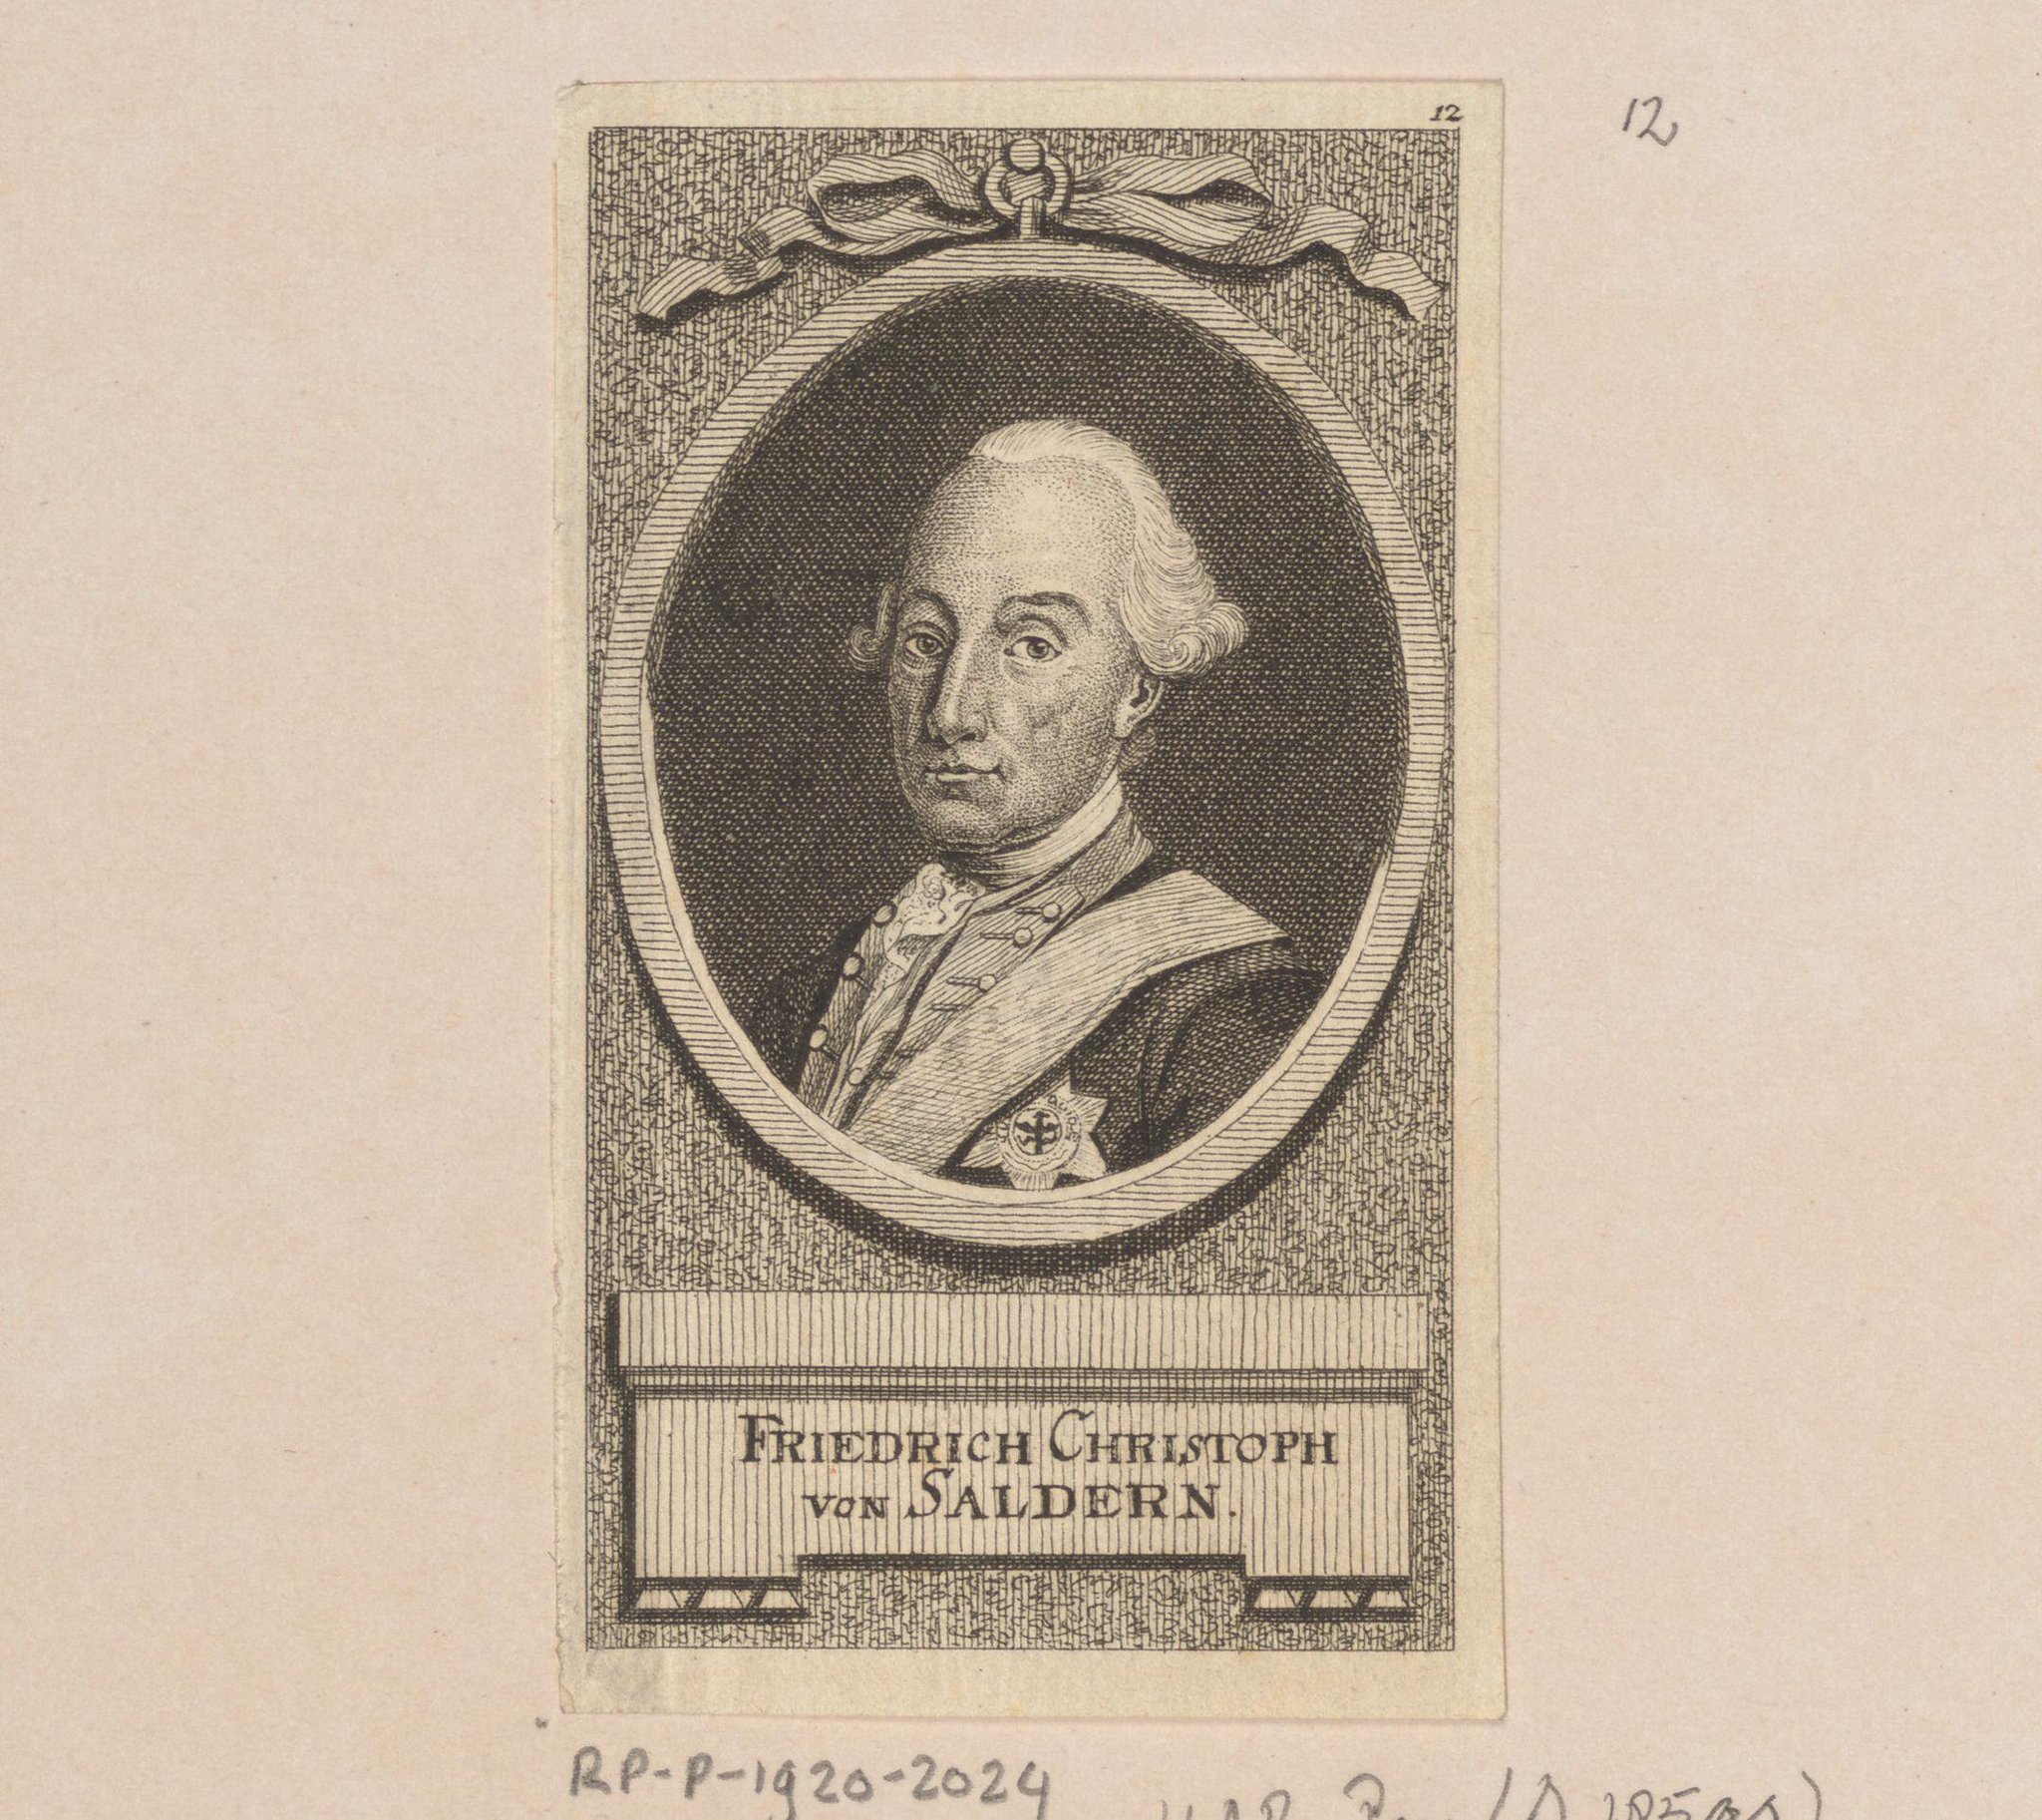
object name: print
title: Portret van Friedrich Christoph von Saldern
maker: daniel berger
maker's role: print maker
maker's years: 1744-1824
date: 1783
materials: paper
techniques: engraving, etching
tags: commander-in-chief, general, marshal, historical persons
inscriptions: collector's mark: Lugt 2228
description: Deze prent maakt deel uit van een grotere prent met tenminste drie portretten.